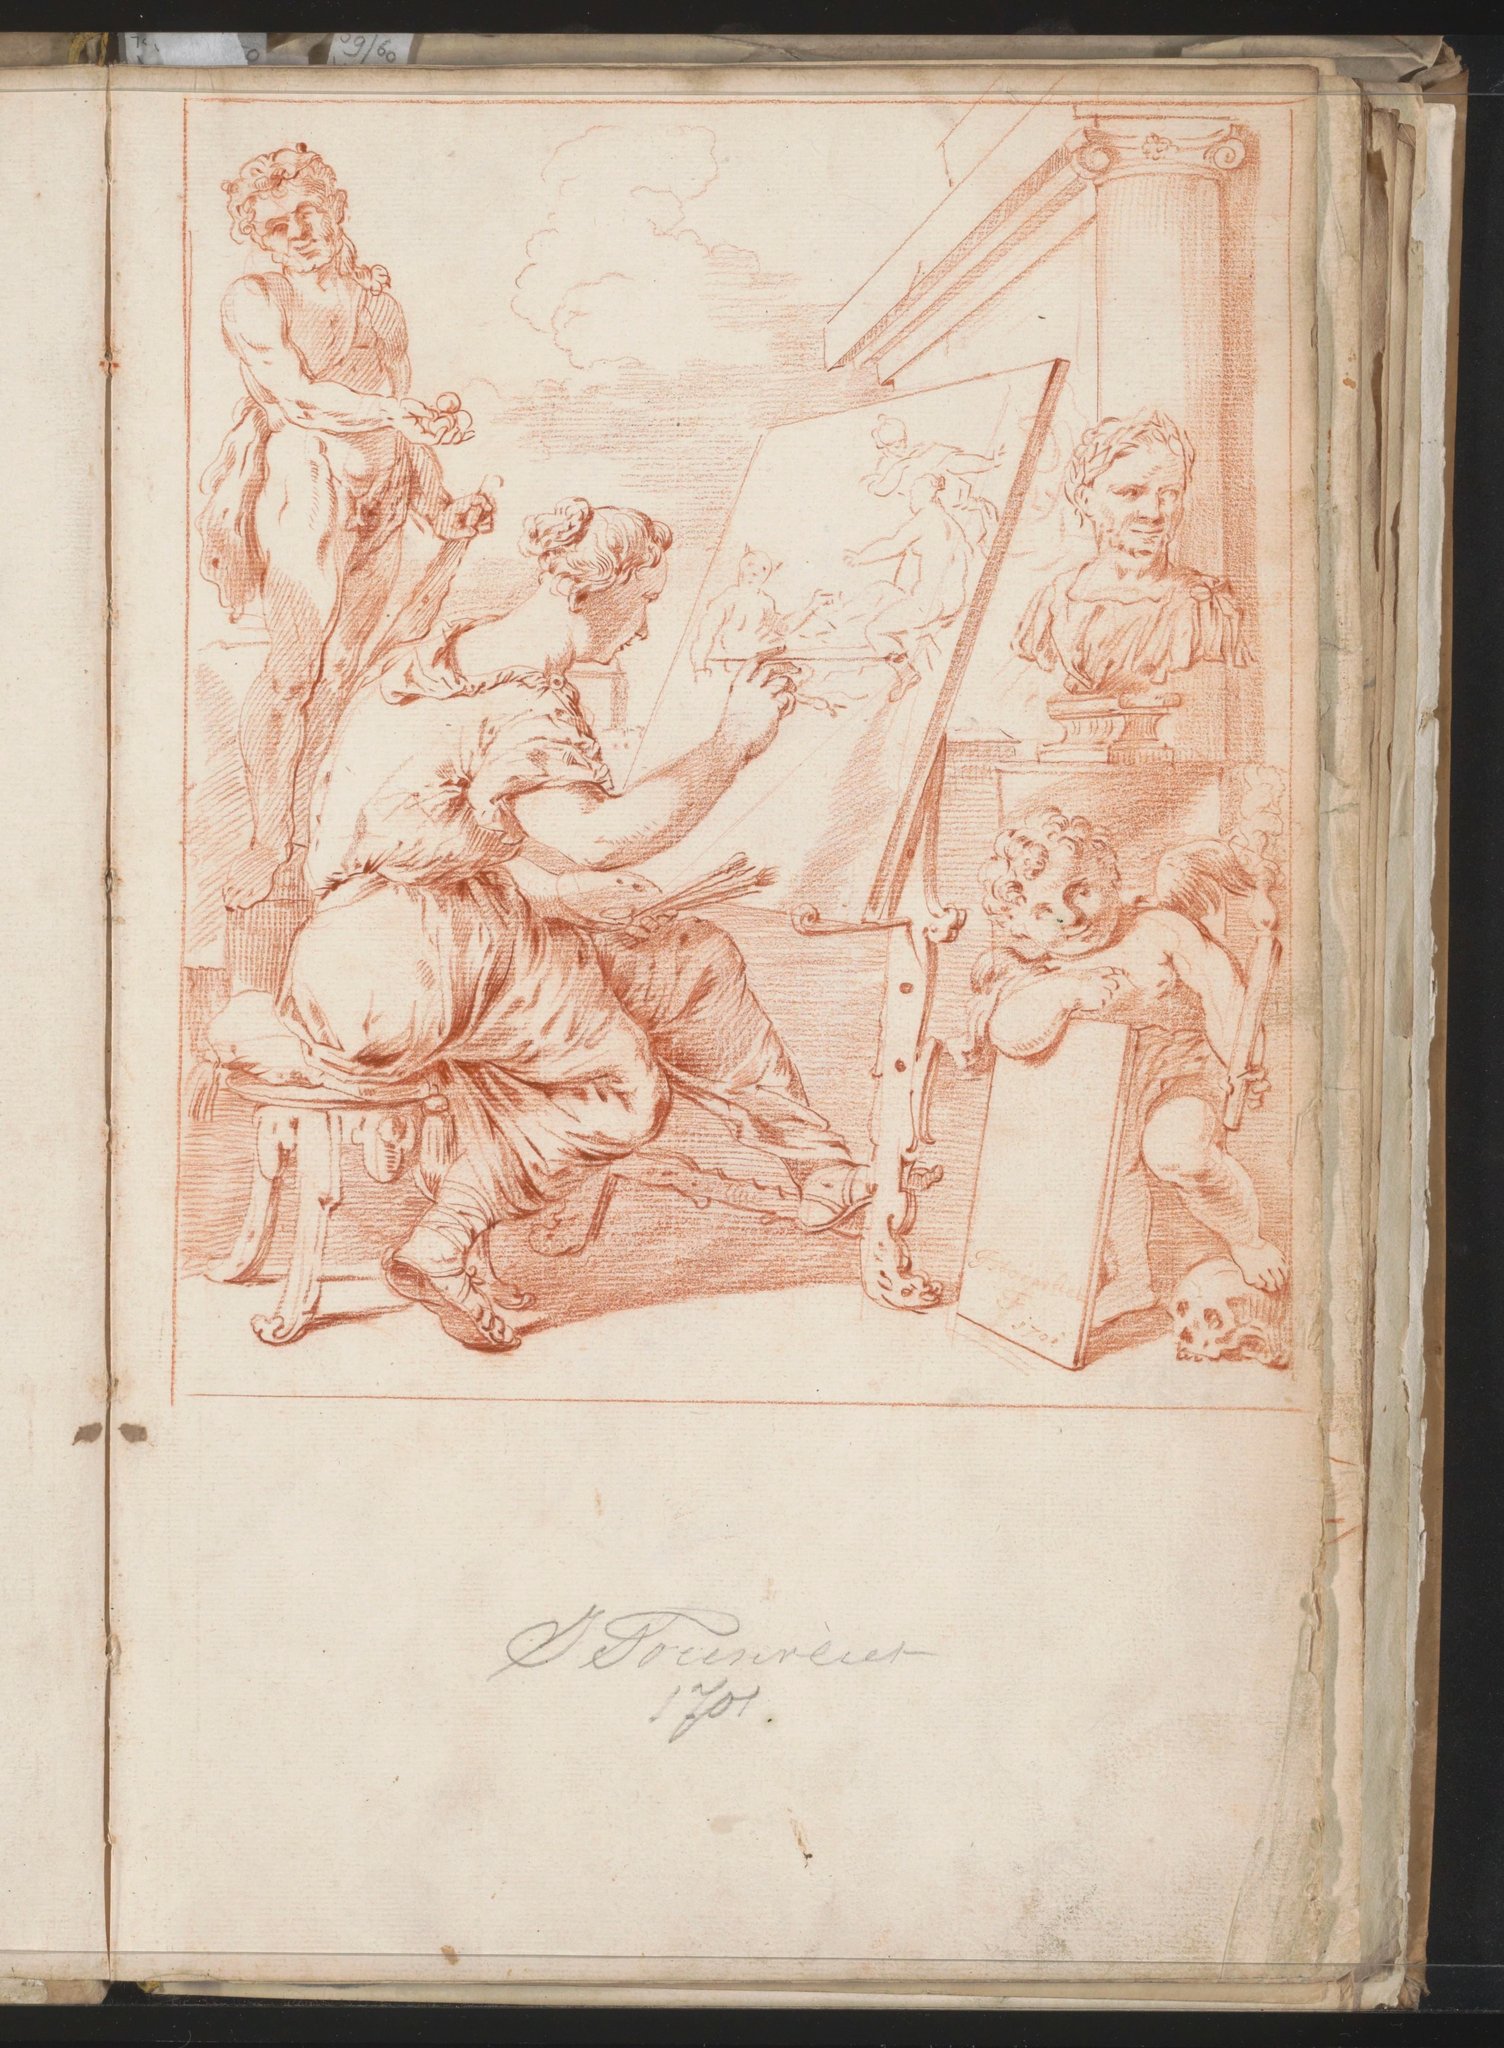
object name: sketchbook leaf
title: Pictura (de Schilderkunst)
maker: jacob toorenvliet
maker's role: draughtsman, painter, print maker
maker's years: 1640-1719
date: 1701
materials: chalk, paper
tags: 'pictura', symbolic representations, allegories and emblems ~ painting; 'pittura' (ripa)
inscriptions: signature and date: ‘Toorenvliet/ F 1701/ J Toorenvliet/ 1701.’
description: De personificatie van Pictura (de Schilderkunst), gekleed in een toga en sandalen, zit op een kruk achter een schildersezel met een palet en penselen in de hand. Achter haar staat Hercules met een mantel over zijn schouders en een knots in de hand. Hij reikt Pictura drie appels aan. Achter de ezel een bouwwerk met een Ionische zuil en een buste van een man op een sokkel. Rechts op de voorgrond een putto die een tablet vasthoudt en met zijn voet op een menselijke schedel staat. Tekening in een kader. Blad 1 recto uit een schetsboek met 63 bladen.